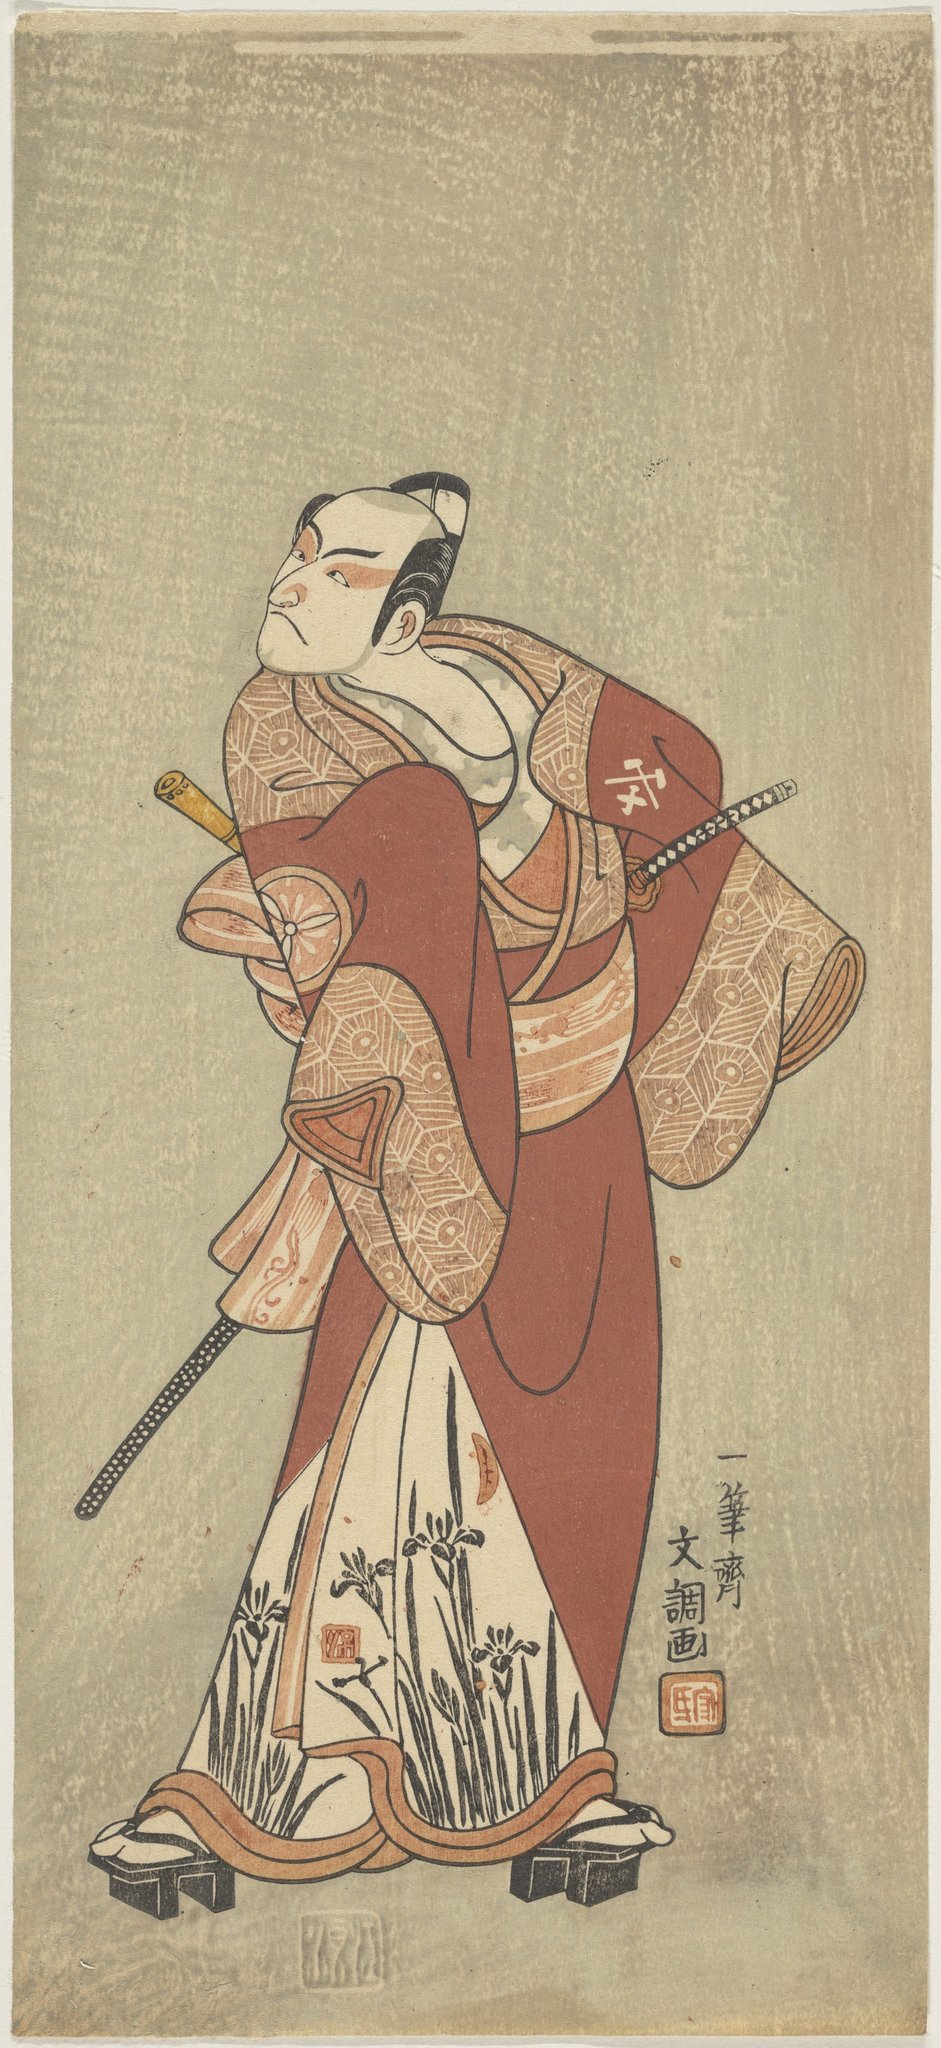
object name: print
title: The Actor Matsumoto Koshiro 3rd in an Unidentified Role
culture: japanese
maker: ippitsusai bunchō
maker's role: artist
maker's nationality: japanese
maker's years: 1765-1792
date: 1769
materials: ink, paper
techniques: woodblock print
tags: men,actors